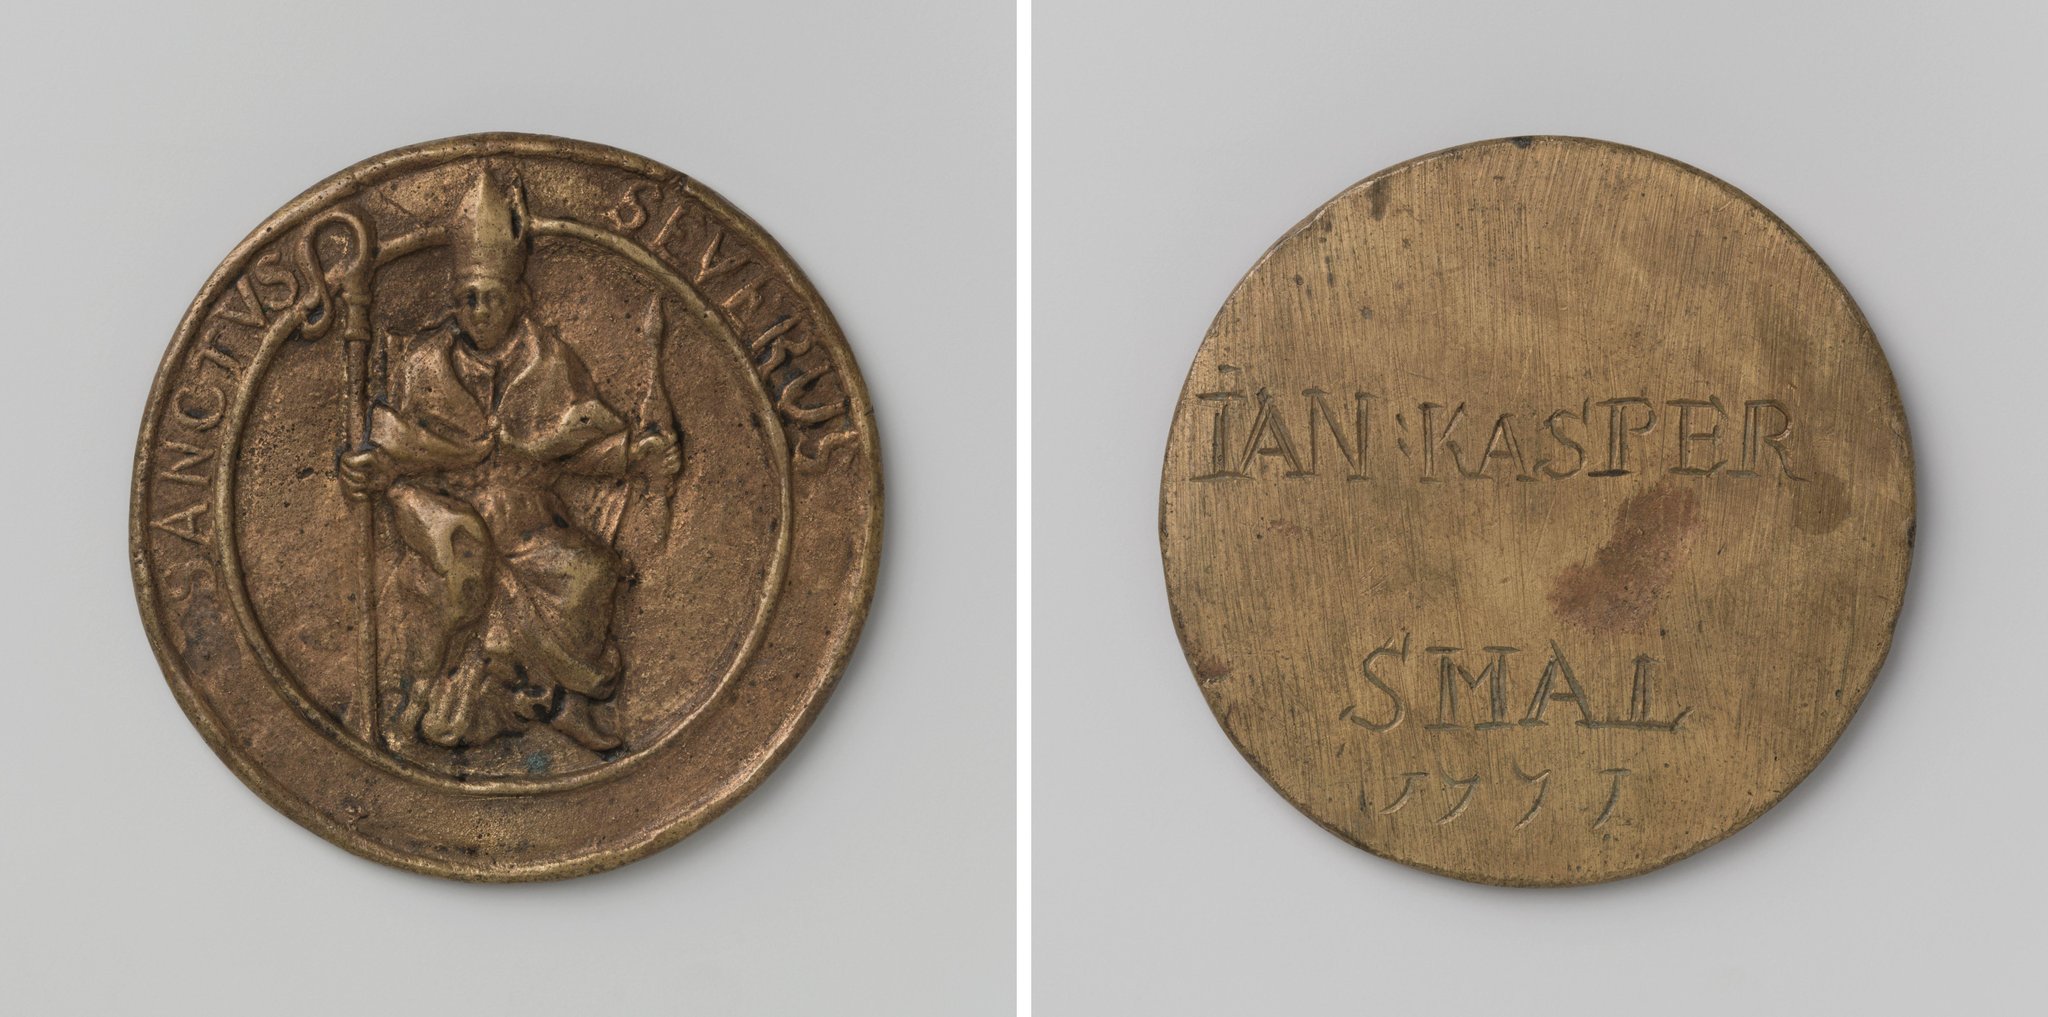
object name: medal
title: Drappiers- en gewantmakersgilde van Maastricht, gildepenning van Jan Kasper Smal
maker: Anonymous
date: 1771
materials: brass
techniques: casting, engraving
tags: maastricht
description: Messing penning. Voorzijde: gemijterde St. Severinus met in rechterhand bisschopsstaf en in linkerhand lange weversspoel binnen omschrift. Keerzijde: opschrift.